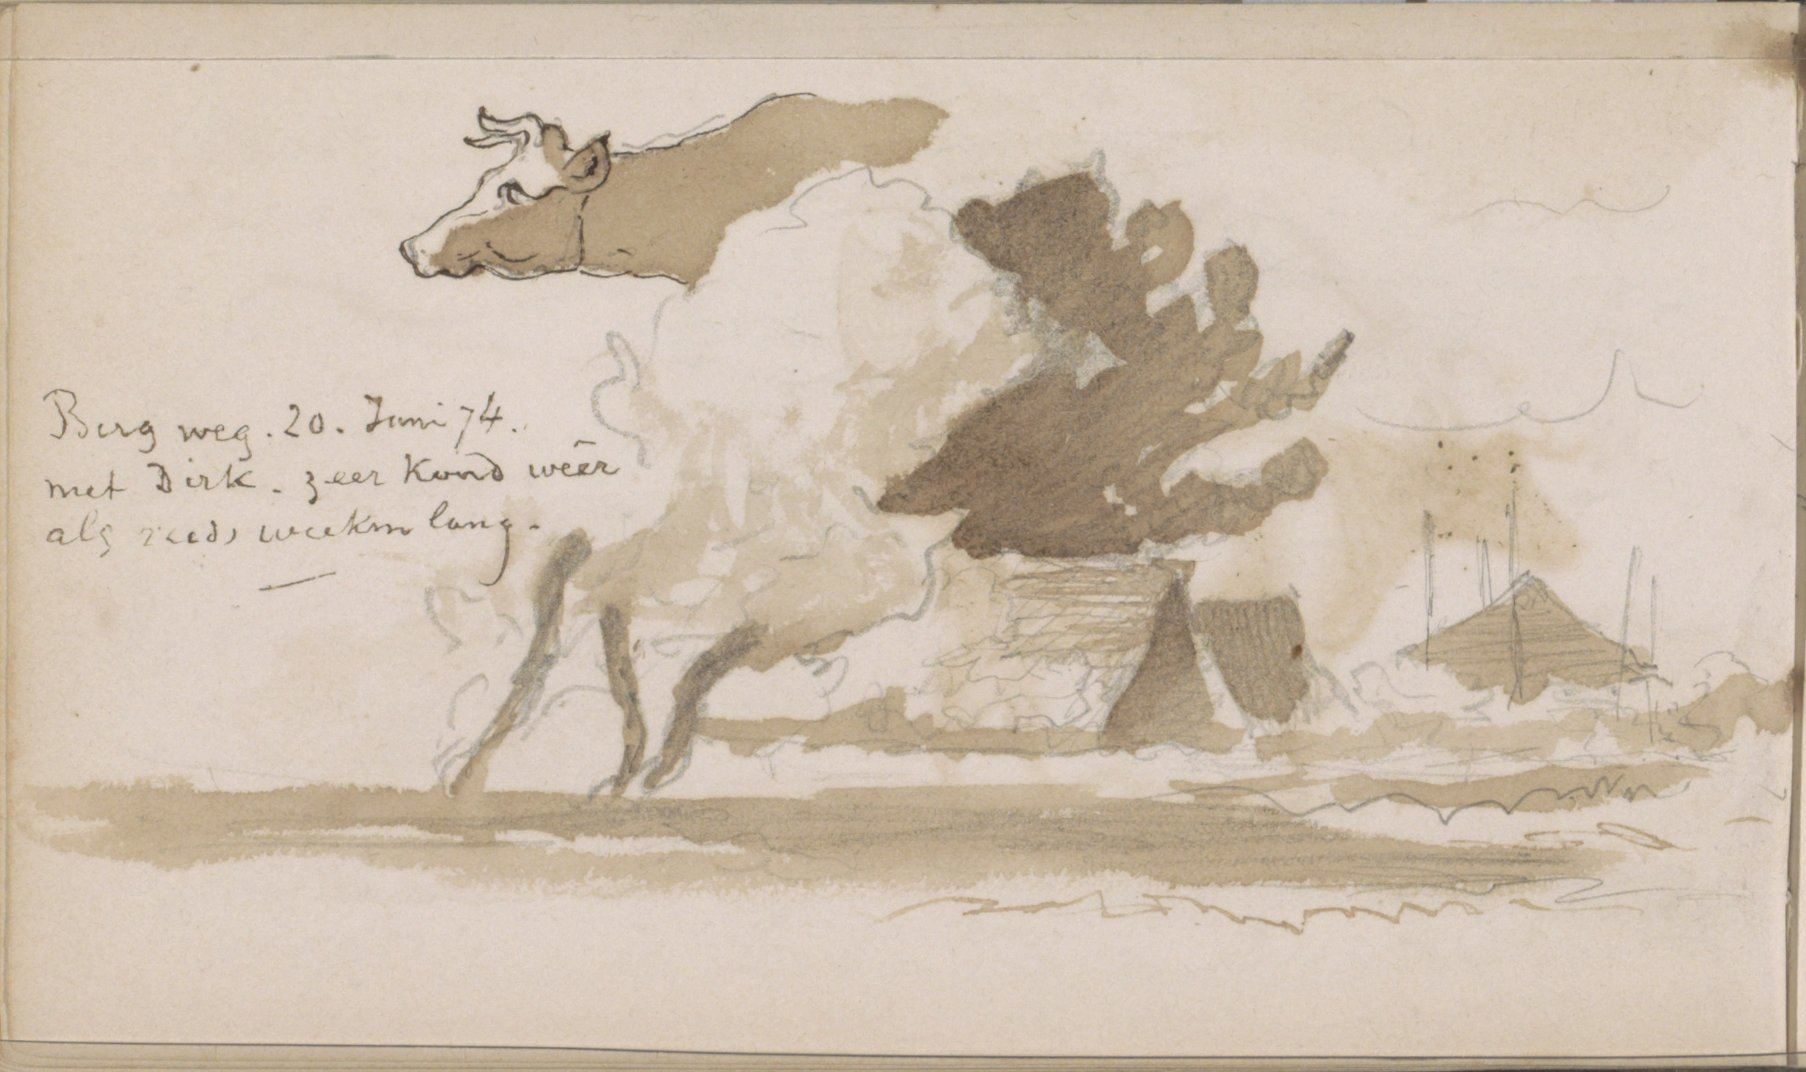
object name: sketchbook leaf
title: Notities en 'My heart is in the Highlands' van Robert Burnes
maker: johannes tavenraat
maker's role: draughtsman, painter, print maker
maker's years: 1809-1881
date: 1811-1873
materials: ink, paper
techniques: pen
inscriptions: date and inscription: ‘25. Nov 73 met Eduard. Dirk, Arnold & Adriane/ te Hillegersberg koffij gedronken. zeer fraai/ stil meer./ "My heart is in the Highlands, my heart is not here [...]’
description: Blad 24 verso uit een schetsboek met 46 bladen.